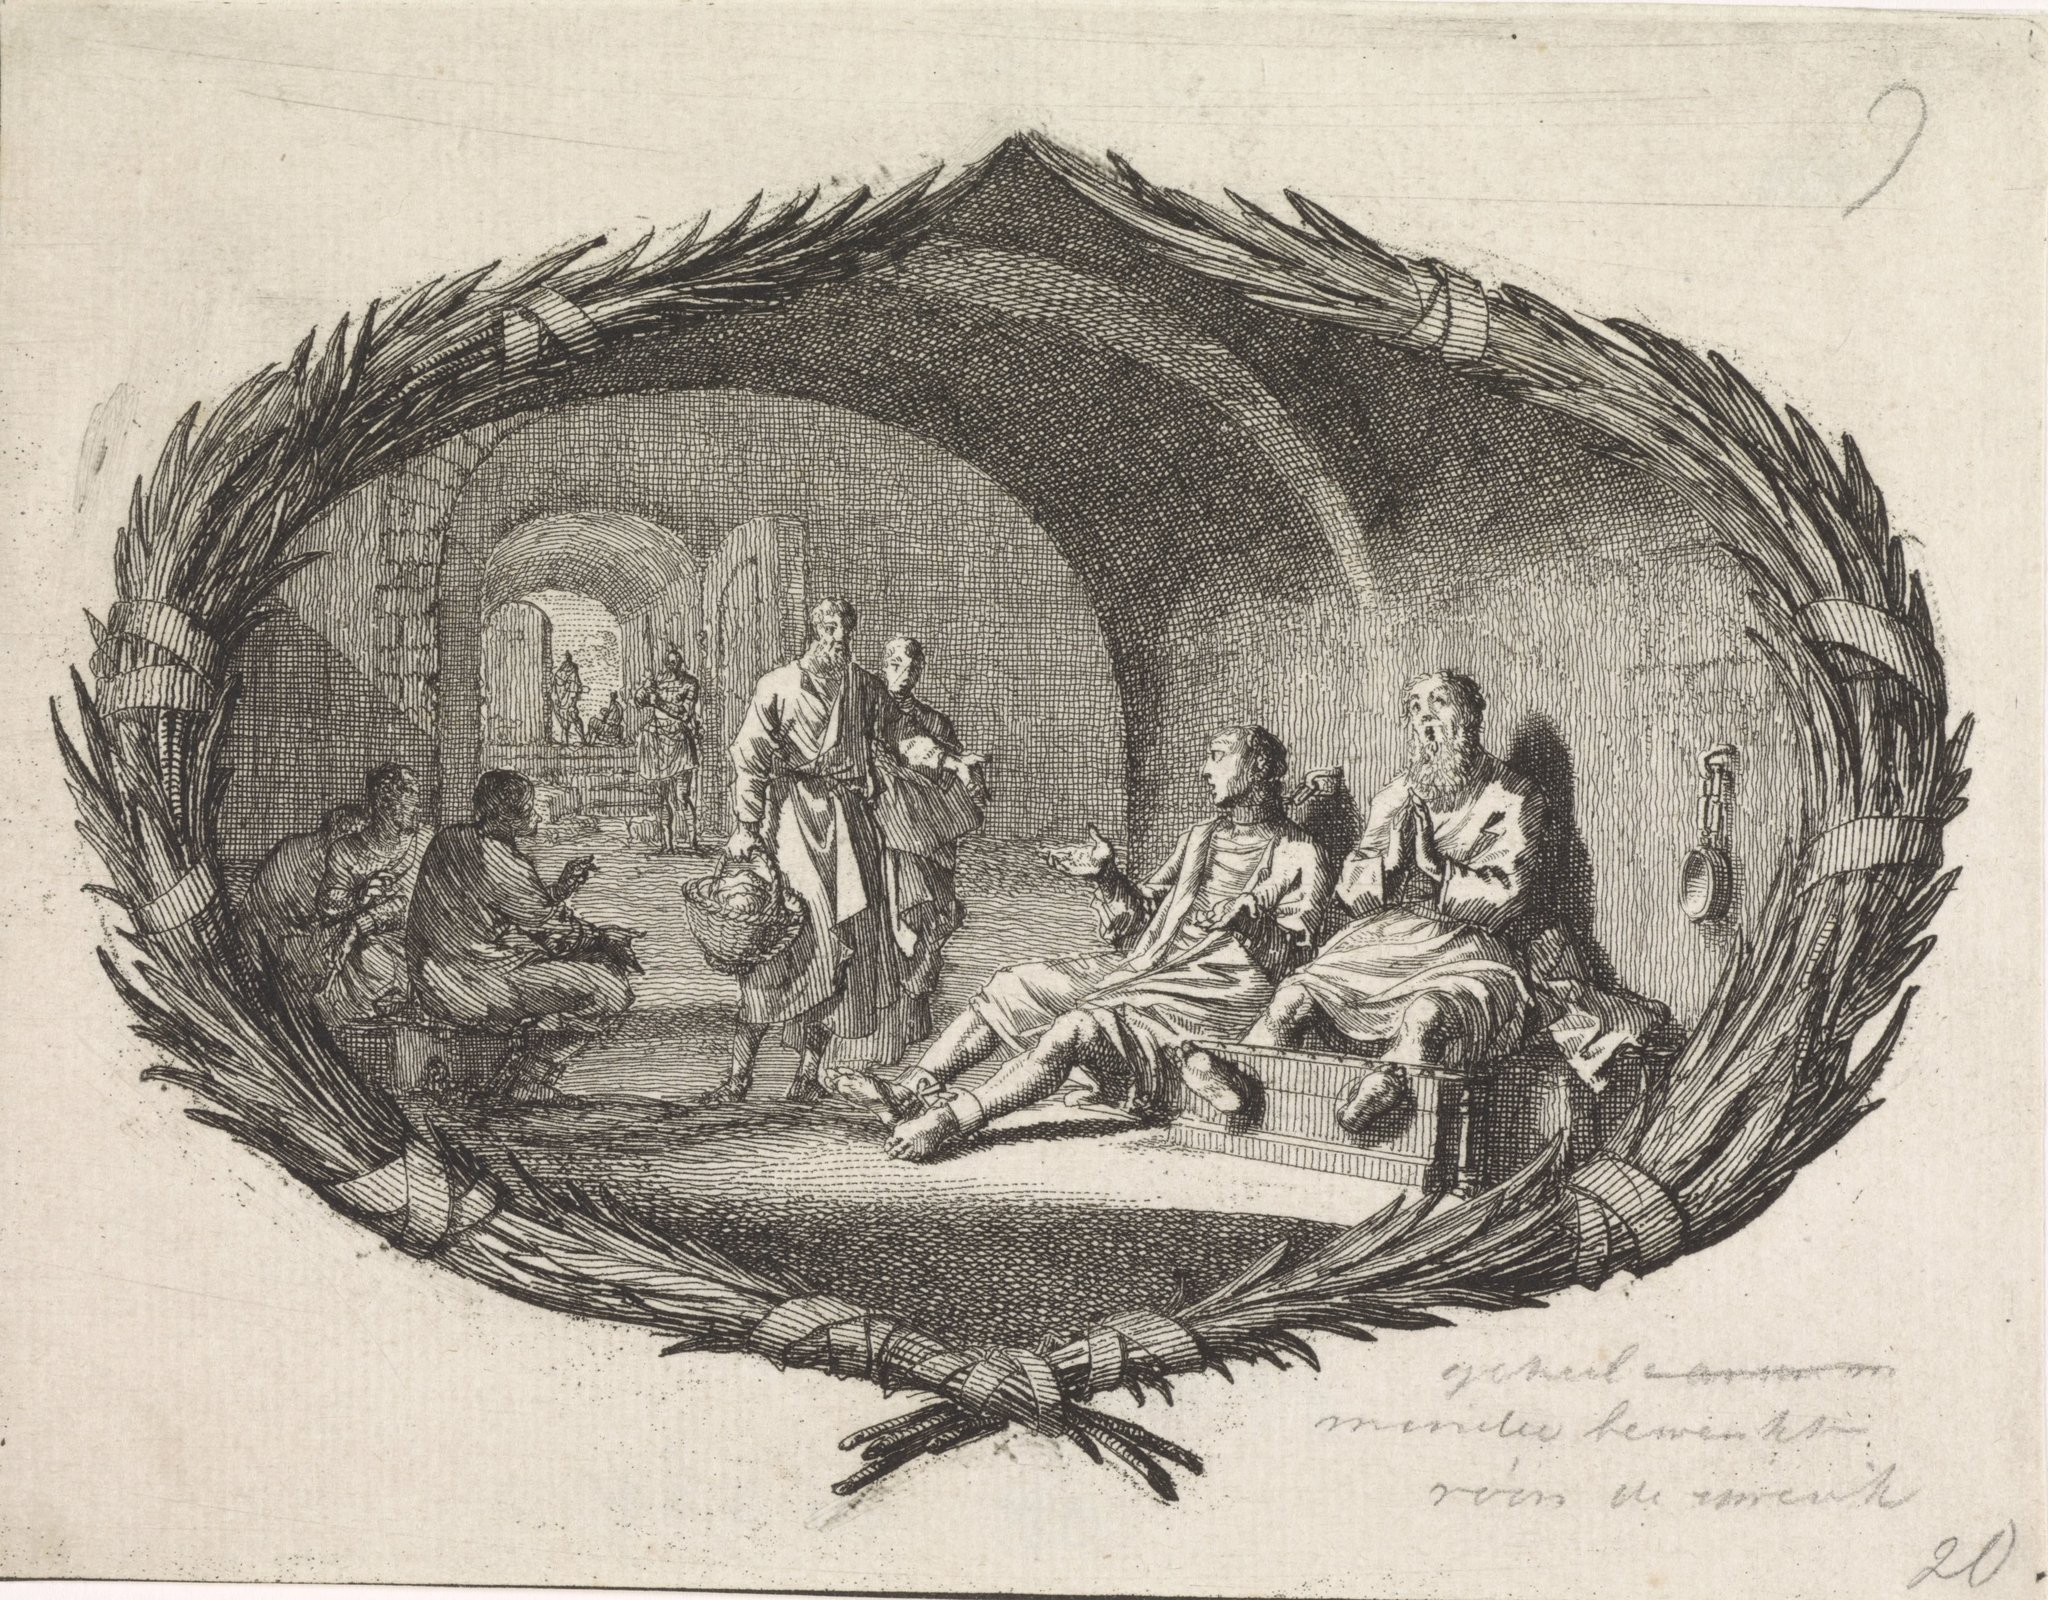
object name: print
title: Gevangenen bezoeken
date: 1700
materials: paper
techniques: etching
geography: amsterdam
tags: prison, jail, visiting or liberating the imprisoned, 'incarceratus solatur' ~ one of the (seven) acts of mercy, prisoner; in fetters, ornament ~ cartouche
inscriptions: collector's mark: Lugt 2228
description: Proefdruk van een boekillustratie voor David Martin. Historie des Ouden en Nieuwen Testaments, verrykt met meer dan vierhonderd printverbeeldingen. Deel II. Amsterdam: Pieter Mortier, 1700.